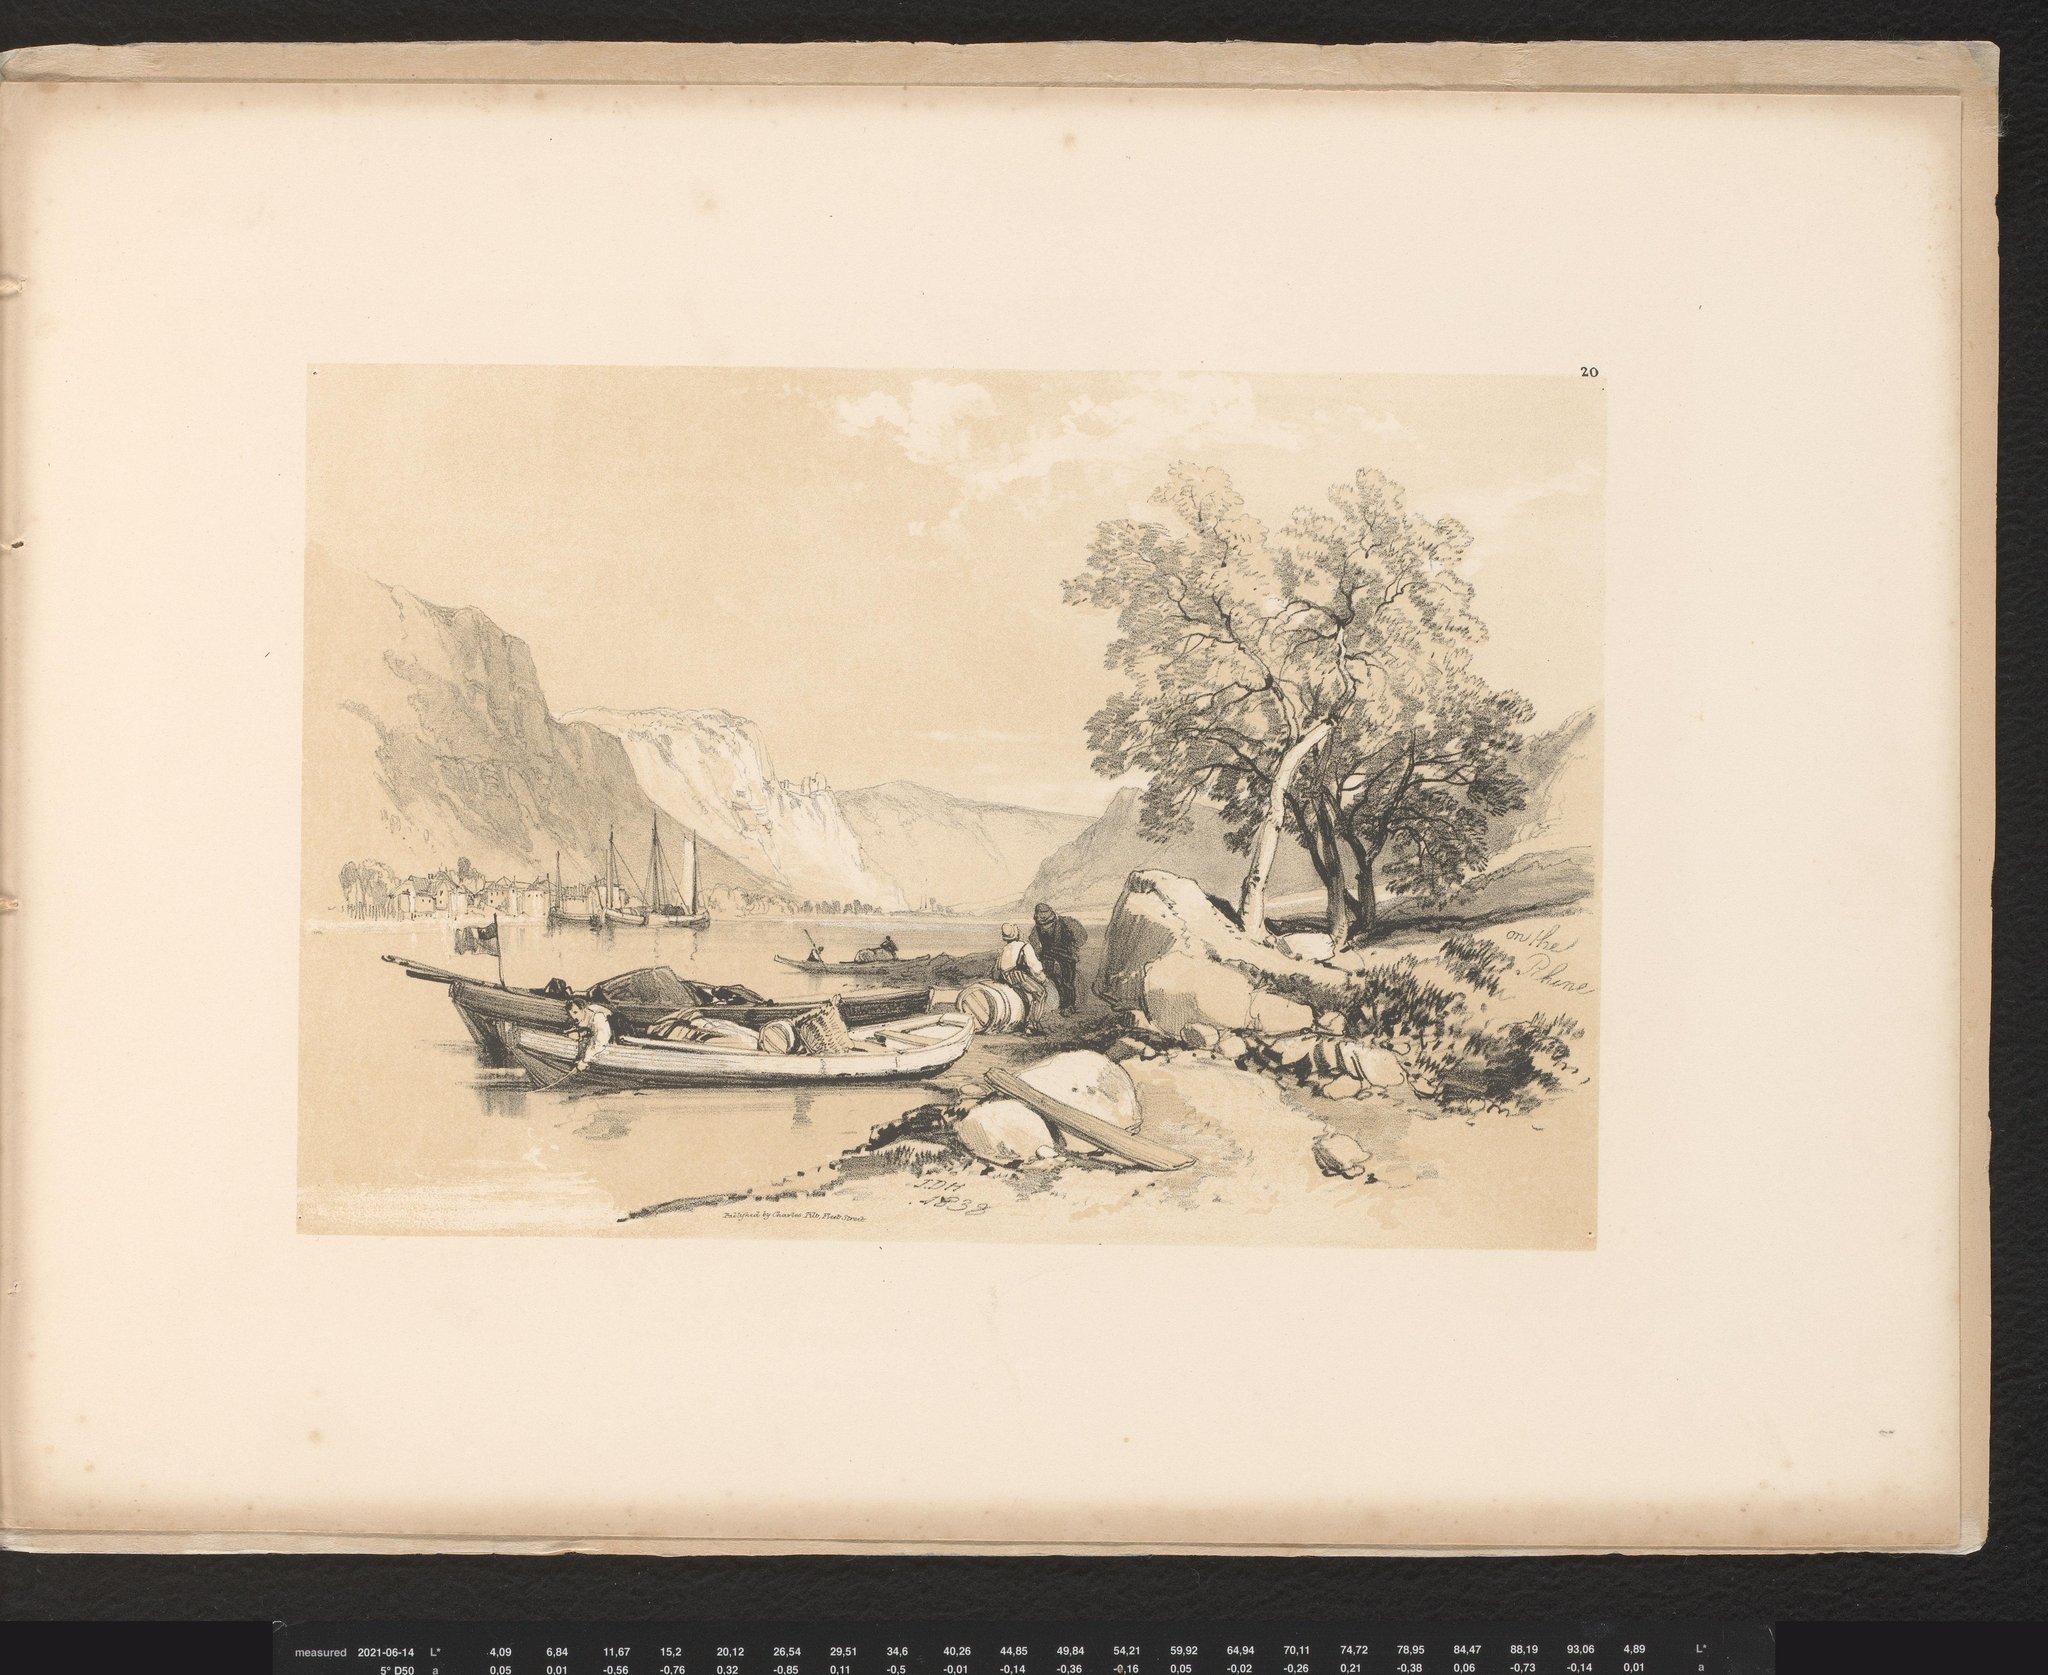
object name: print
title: Tekenboek met werken van James Duffield Harding 1838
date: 1838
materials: paper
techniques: tone lithography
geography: london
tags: rowing-boat, canoe, etc., river (+ landscape with figures, staffage)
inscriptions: collector's mark: Lugt 2228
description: Uitgever Charles Tilt heeft verschillende series uitgegeven over het werk van James Duffield Harding. Deze serie 'Harding's drawing book for the year MDCCCXXXVIII', bestaat uit zes delen met elk vier lithografieën.